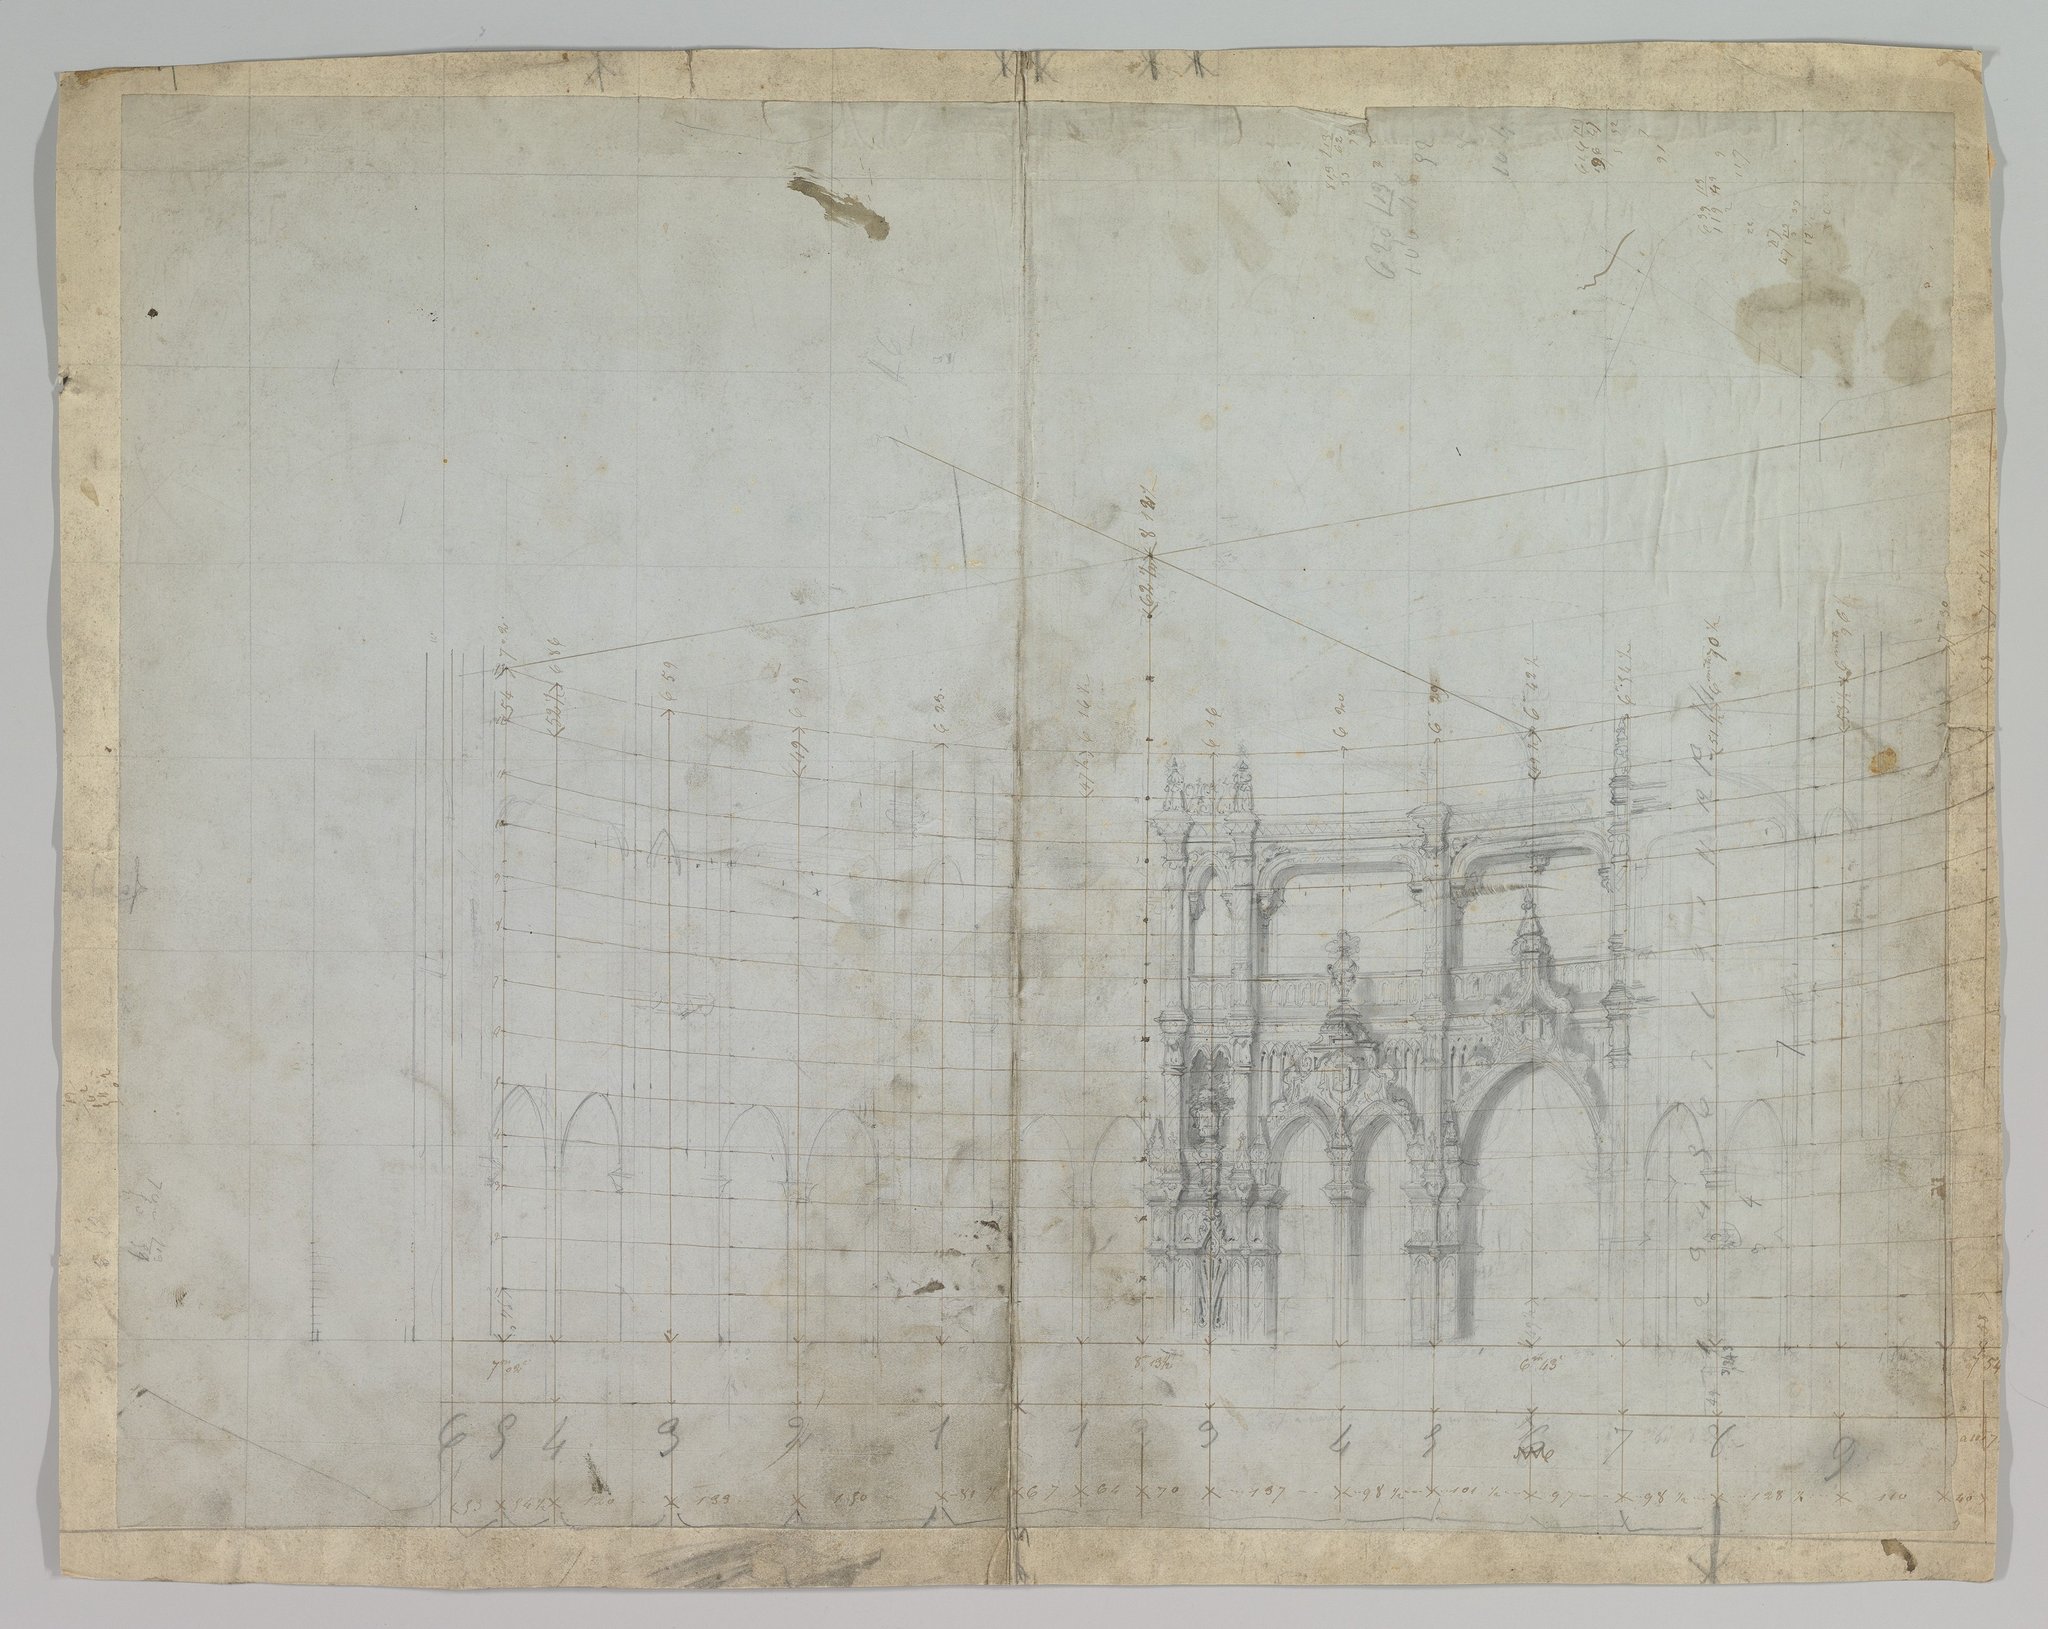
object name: drawing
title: Design for a Stage Set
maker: eugène cicéri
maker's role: artist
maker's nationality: french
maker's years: 1813-1890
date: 1828-1890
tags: stage design